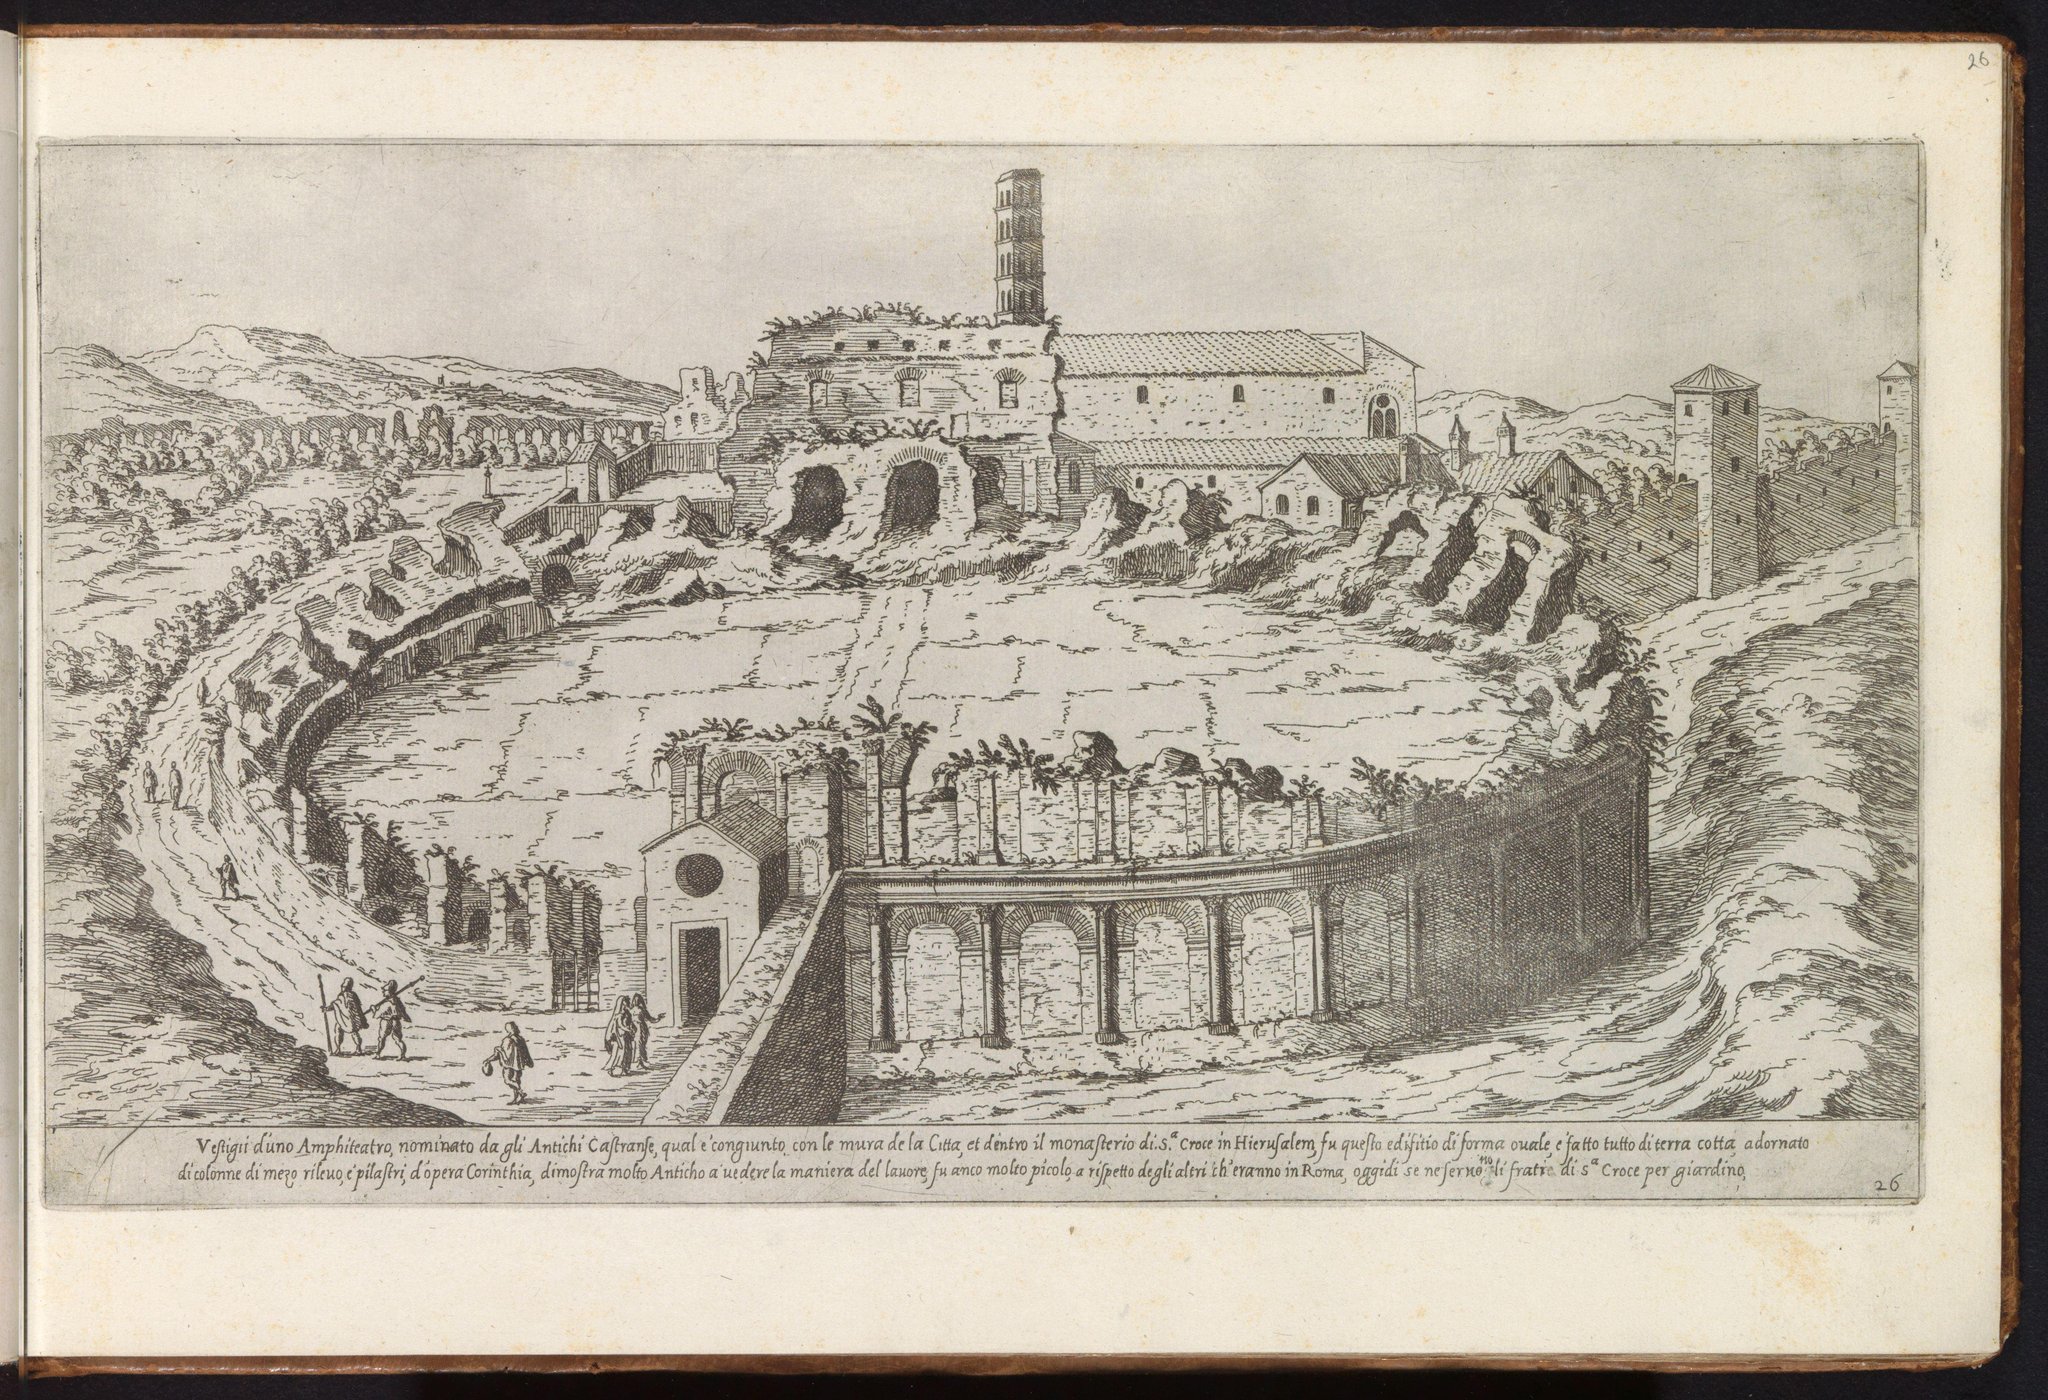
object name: album leaf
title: Bouwwerken uit de oudheid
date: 1575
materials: paper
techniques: engraving, etching, intaglio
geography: italy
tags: city-view, and landscape with man-made constructions, ruin of a building ~ architecture, landscape with ruins, theatre (building) - aa - open-air performances, city-gate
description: Gezicht op de resten van het Amphitheatrum Castrense te Rome. Onderschrift in het Italiaans. Prent maakt deel uit van een album.